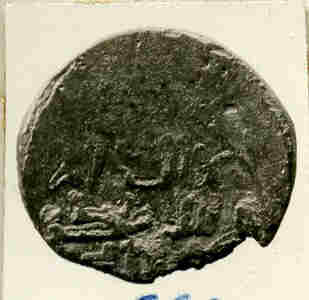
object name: coin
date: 701-800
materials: copper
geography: iran